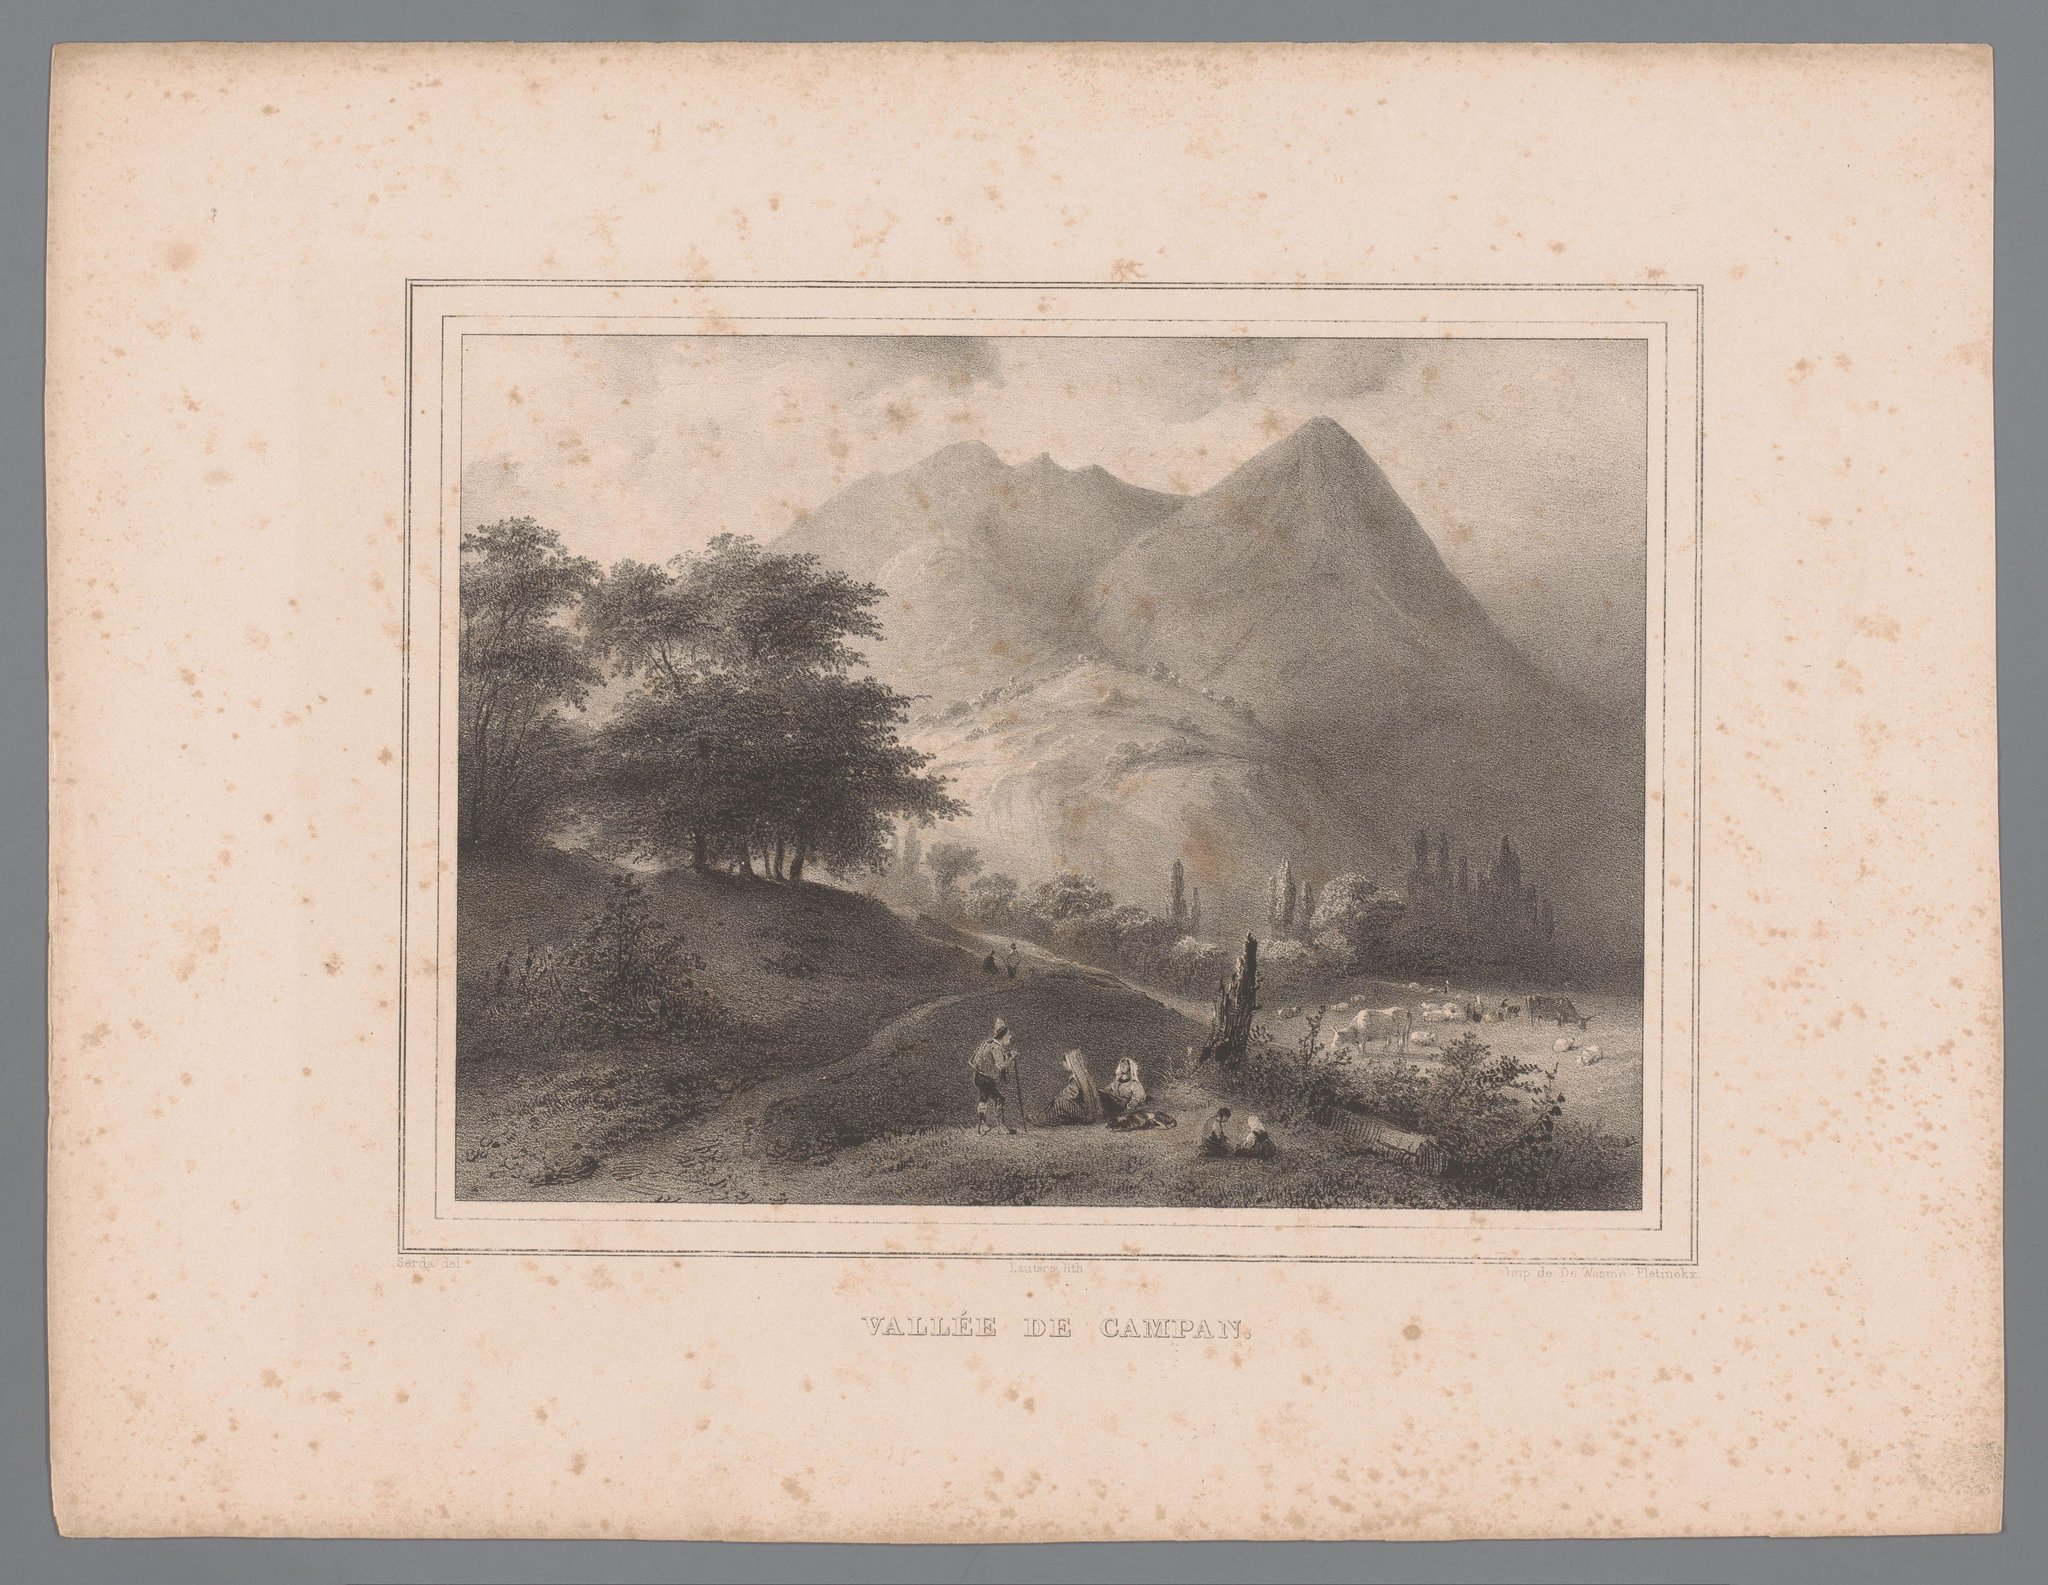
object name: print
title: Vallée de Campan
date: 1816-1851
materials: paper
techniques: lithograph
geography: brussels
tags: herding, herdsman, herdswoman, shepherd, shepherdess, cowherd, etc., mountains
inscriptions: collector's mark: Lugt 2228